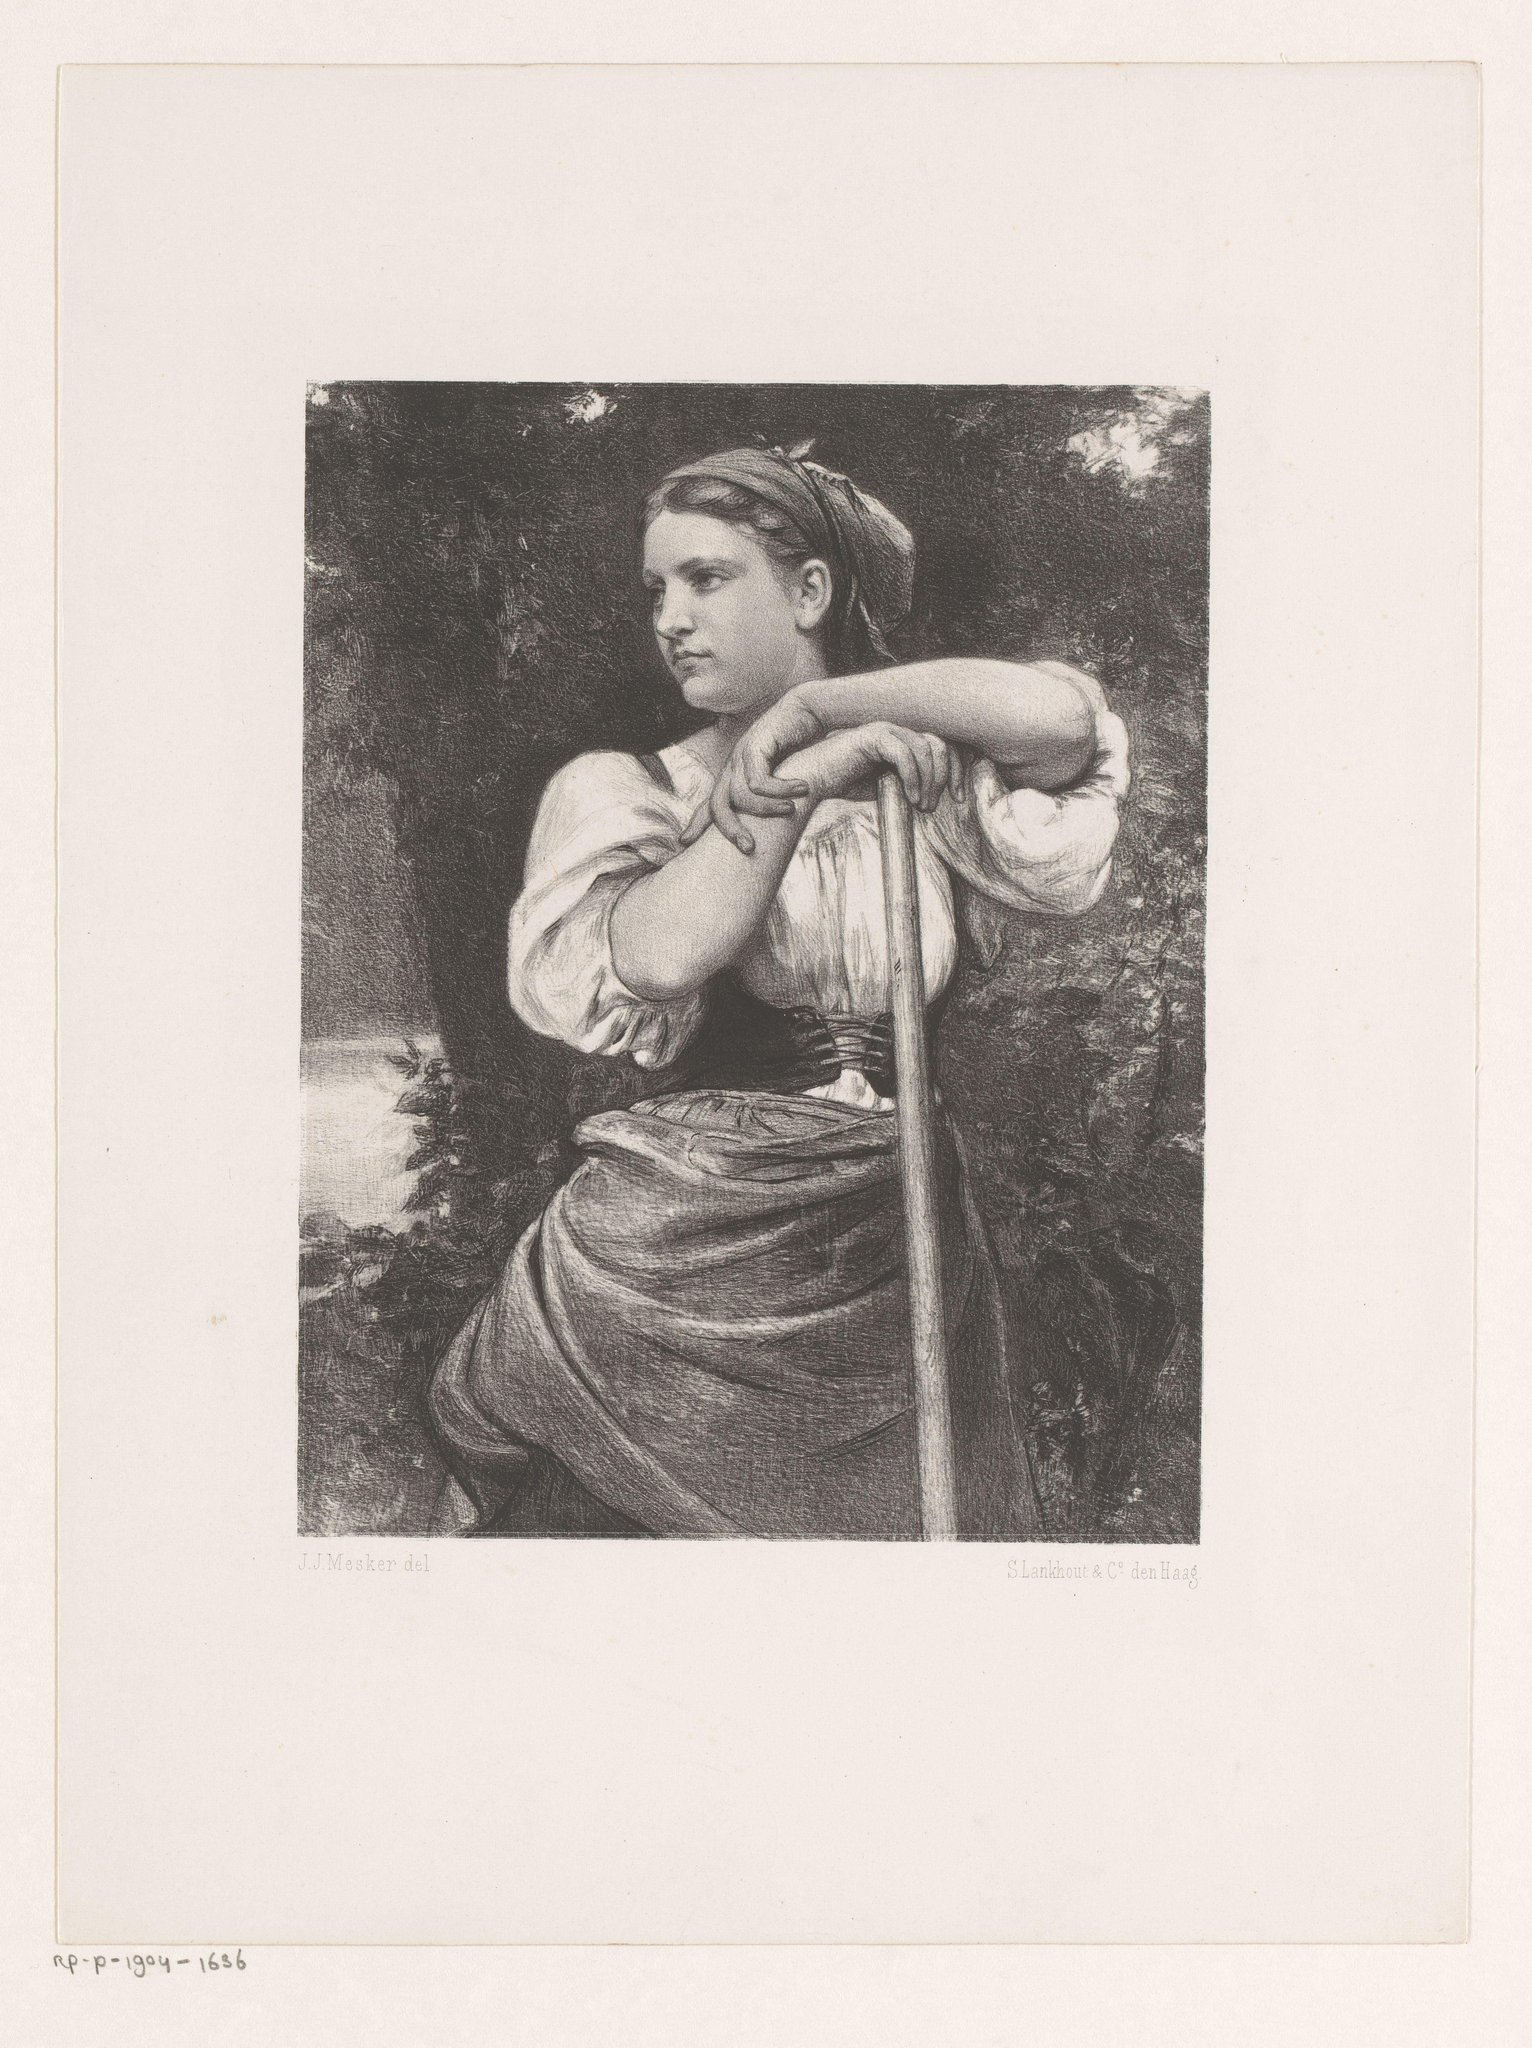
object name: print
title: Jonge boerin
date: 1877-1890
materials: paper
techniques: lithograph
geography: the hague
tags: leaning figure - aa - female human figure, farmers - aa - female farmer, farmer's wife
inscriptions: collector's mark: Lugt 2228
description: De boerin heeft haar mouwen opgestroopt en leunt met beide handen op een stok.